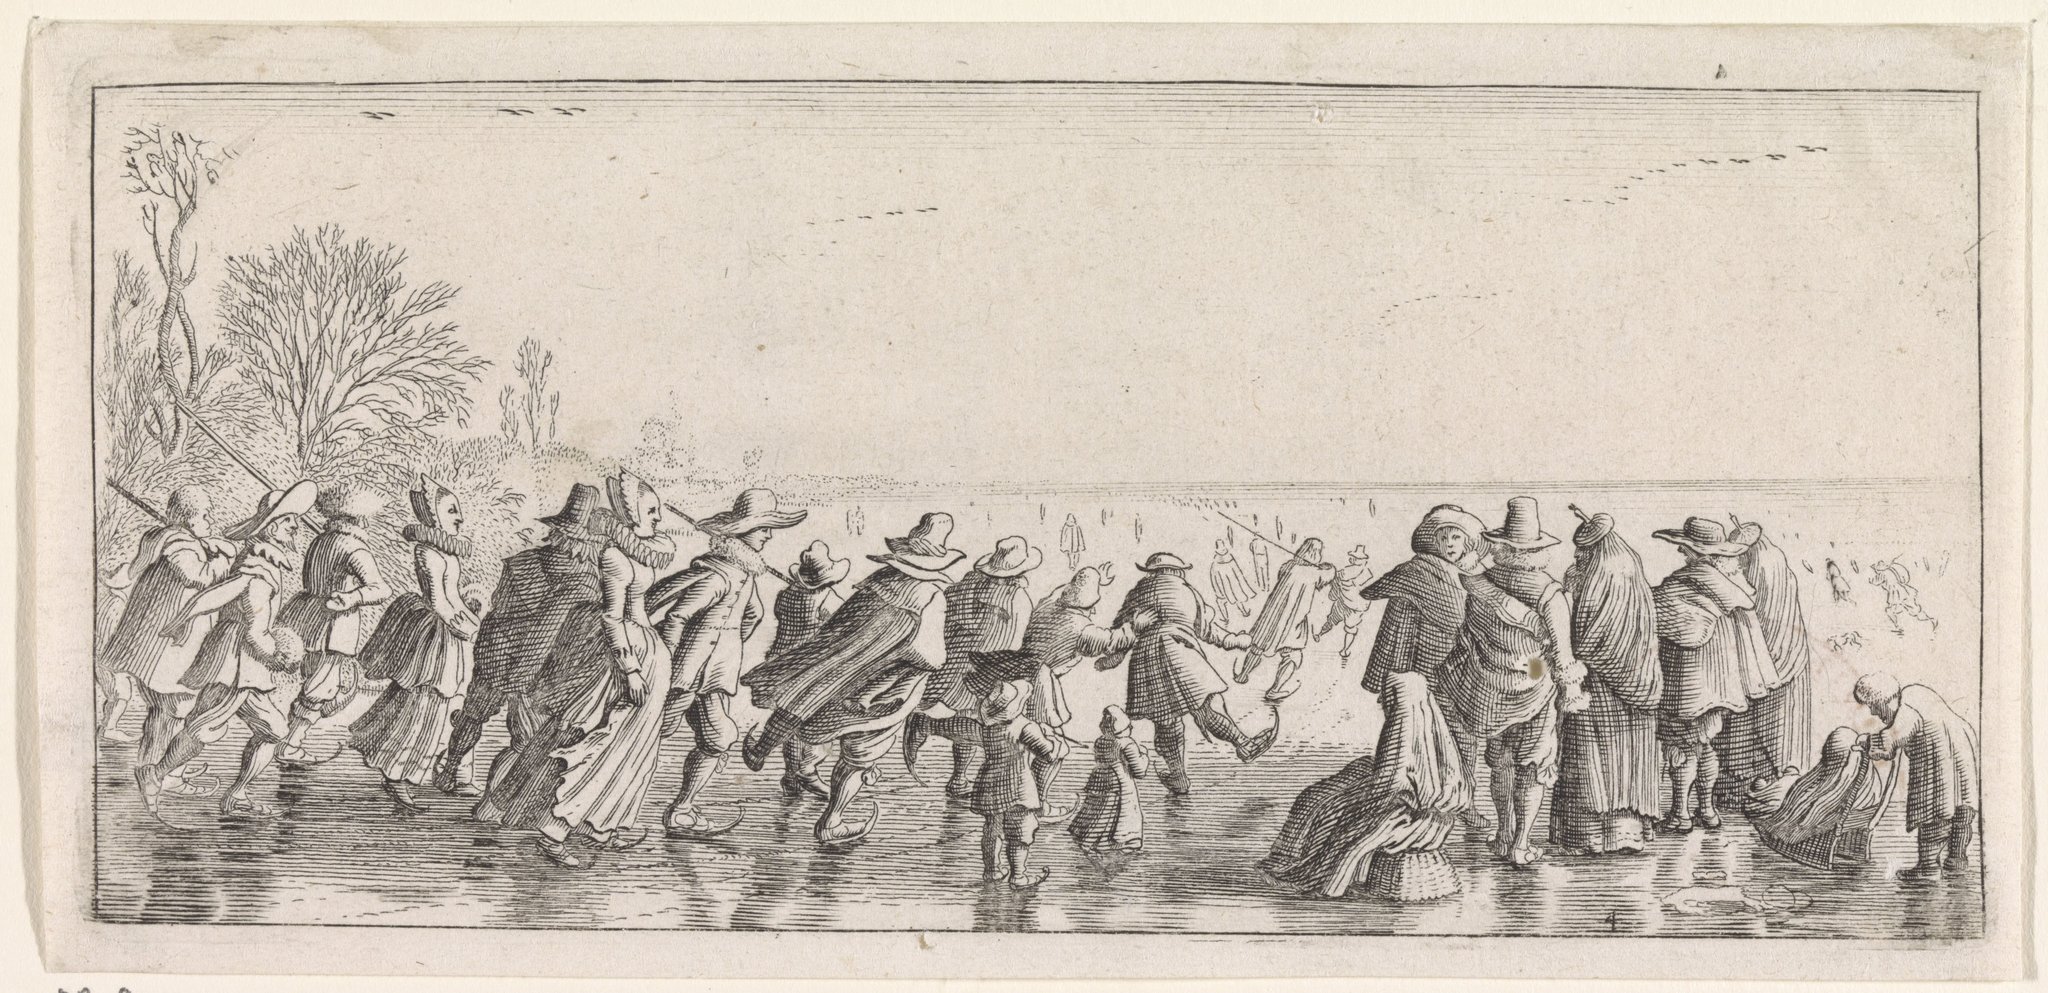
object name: print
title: Schaatsers op het ijs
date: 1627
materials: paper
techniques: engraving, etching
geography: northern netherlands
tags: skates (winter sports)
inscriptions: collector's mark: Lugt 240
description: Prent ook gebruikt als boekillustratie in: Campanus, M., Colevelt, J.J. Craen, A.P., Robbertzen, J. Amsterdamsche Pegasus, waer in (uyt lust) byeen vergadert zijn veel minnelycke liedekens. Amsterdam: Cornelis Willemsz Blaeu-laken, 1627.